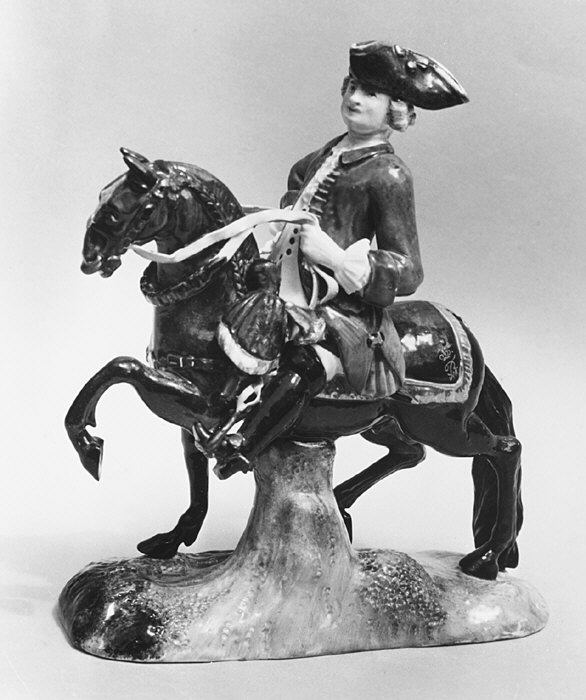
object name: figure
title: Mounted soldier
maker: royal porcelain manufactory, berlin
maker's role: manufactory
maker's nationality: german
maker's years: 1763-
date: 1751-1757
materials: hard paste porcelain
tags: soldiers,men,horses